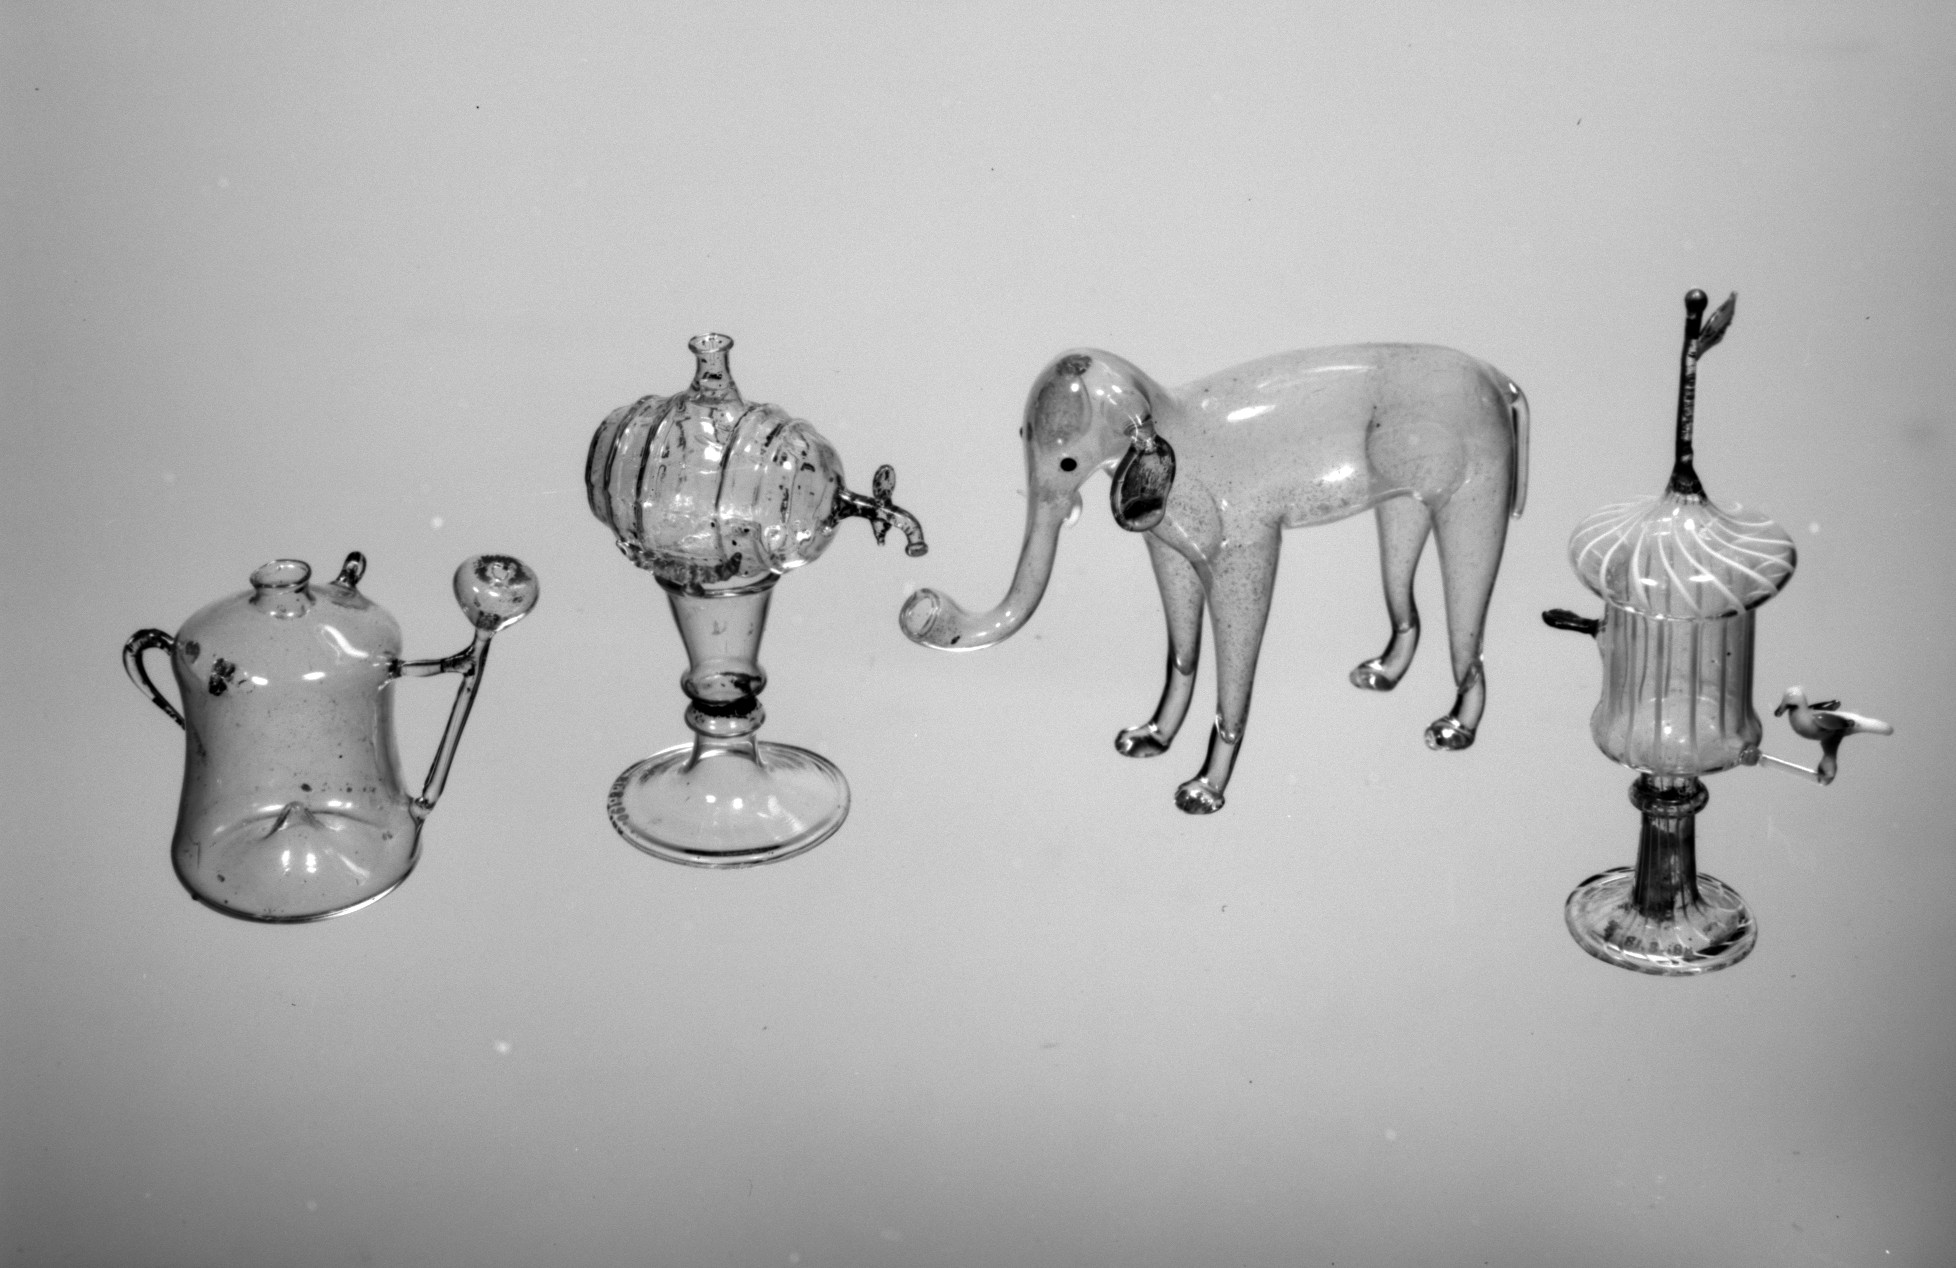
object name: figure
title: Elephant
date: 1701-1900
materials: glass